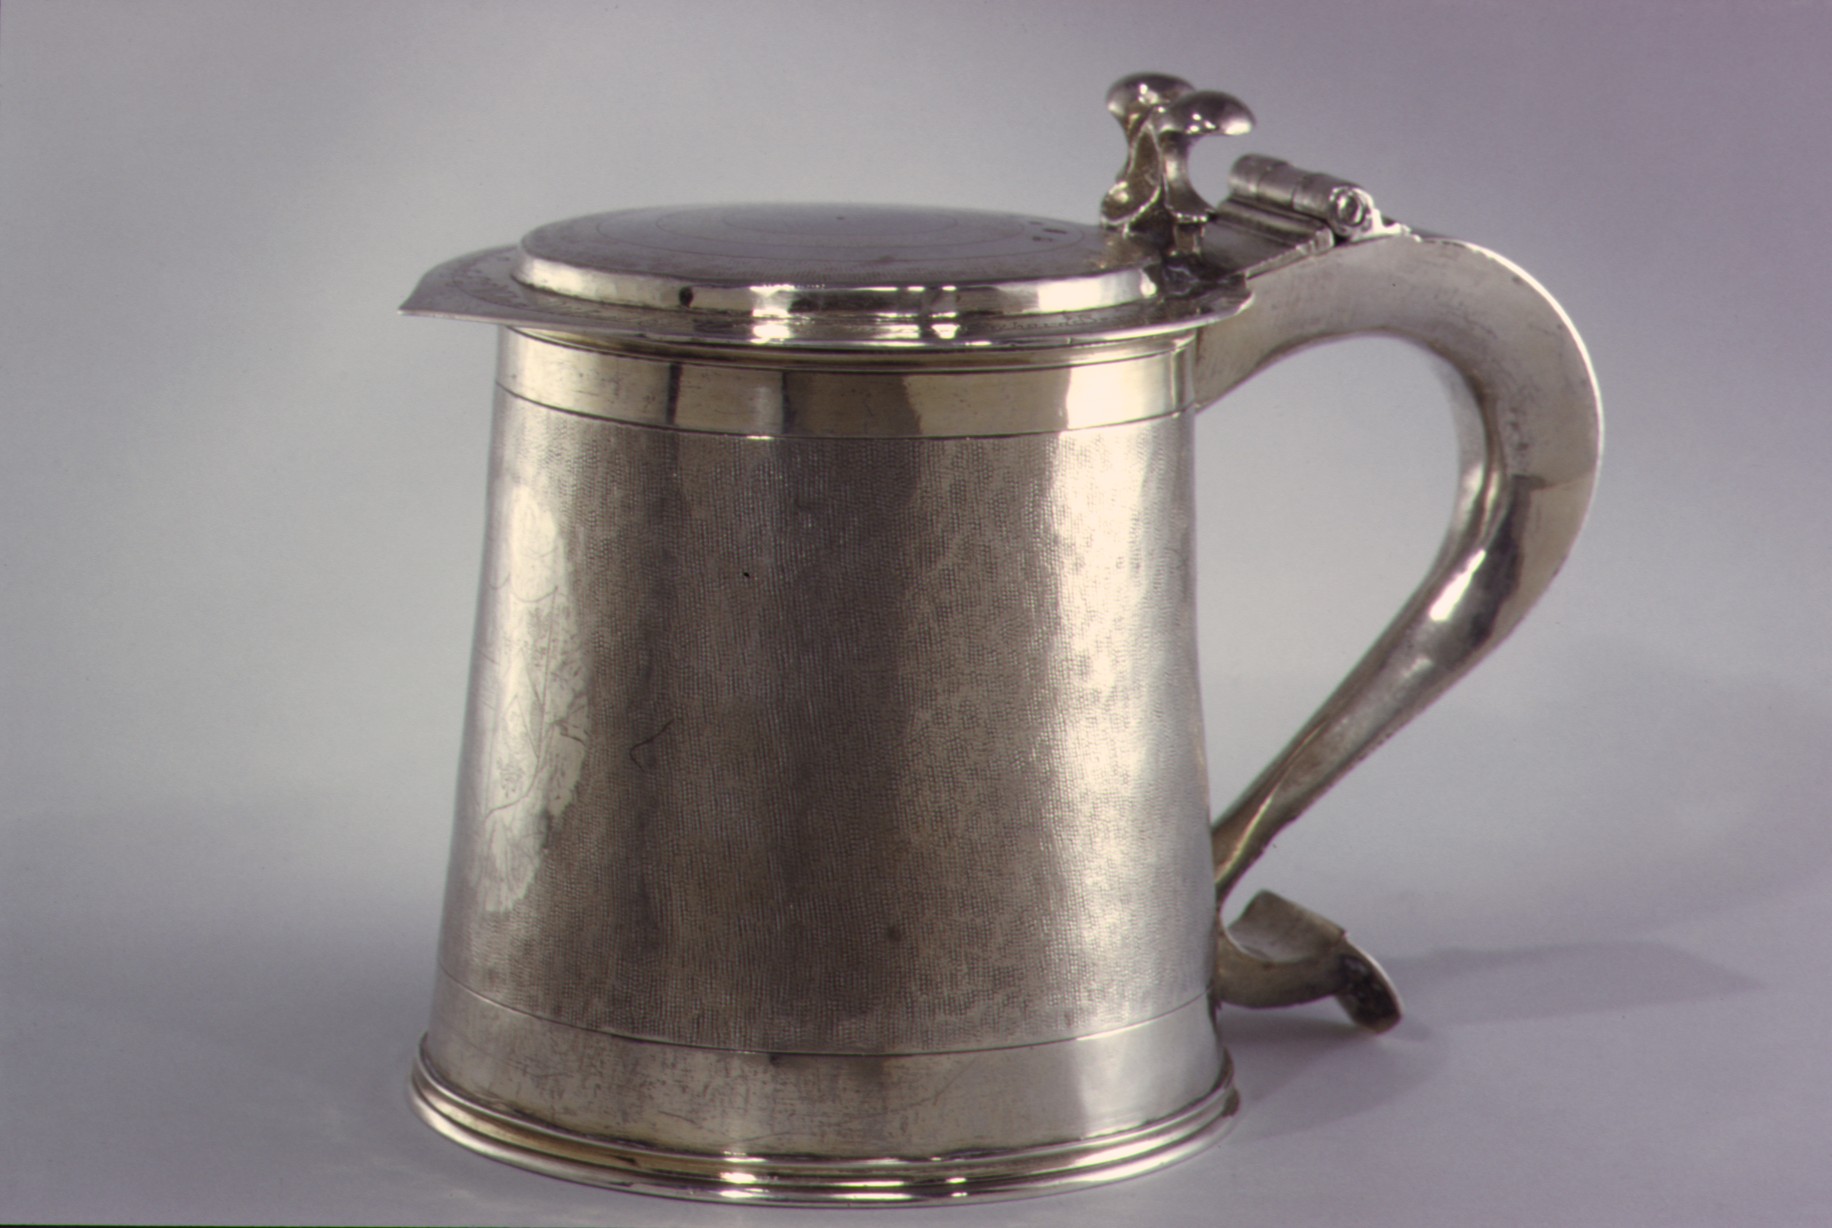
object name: tankard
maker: henry greenway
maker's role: maker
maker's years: 1648-1665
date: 1661-1662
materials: silver